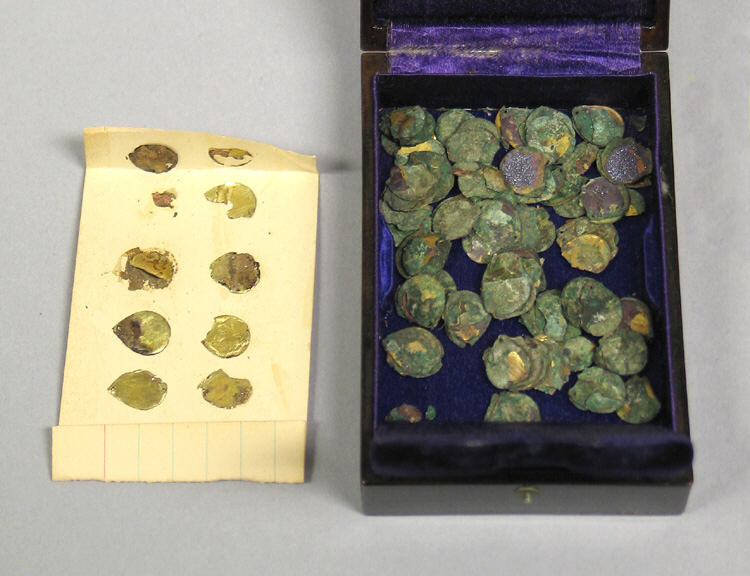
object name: box of remnant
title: Box of Remnants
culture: chinese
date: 618-907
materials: bronze, gilt